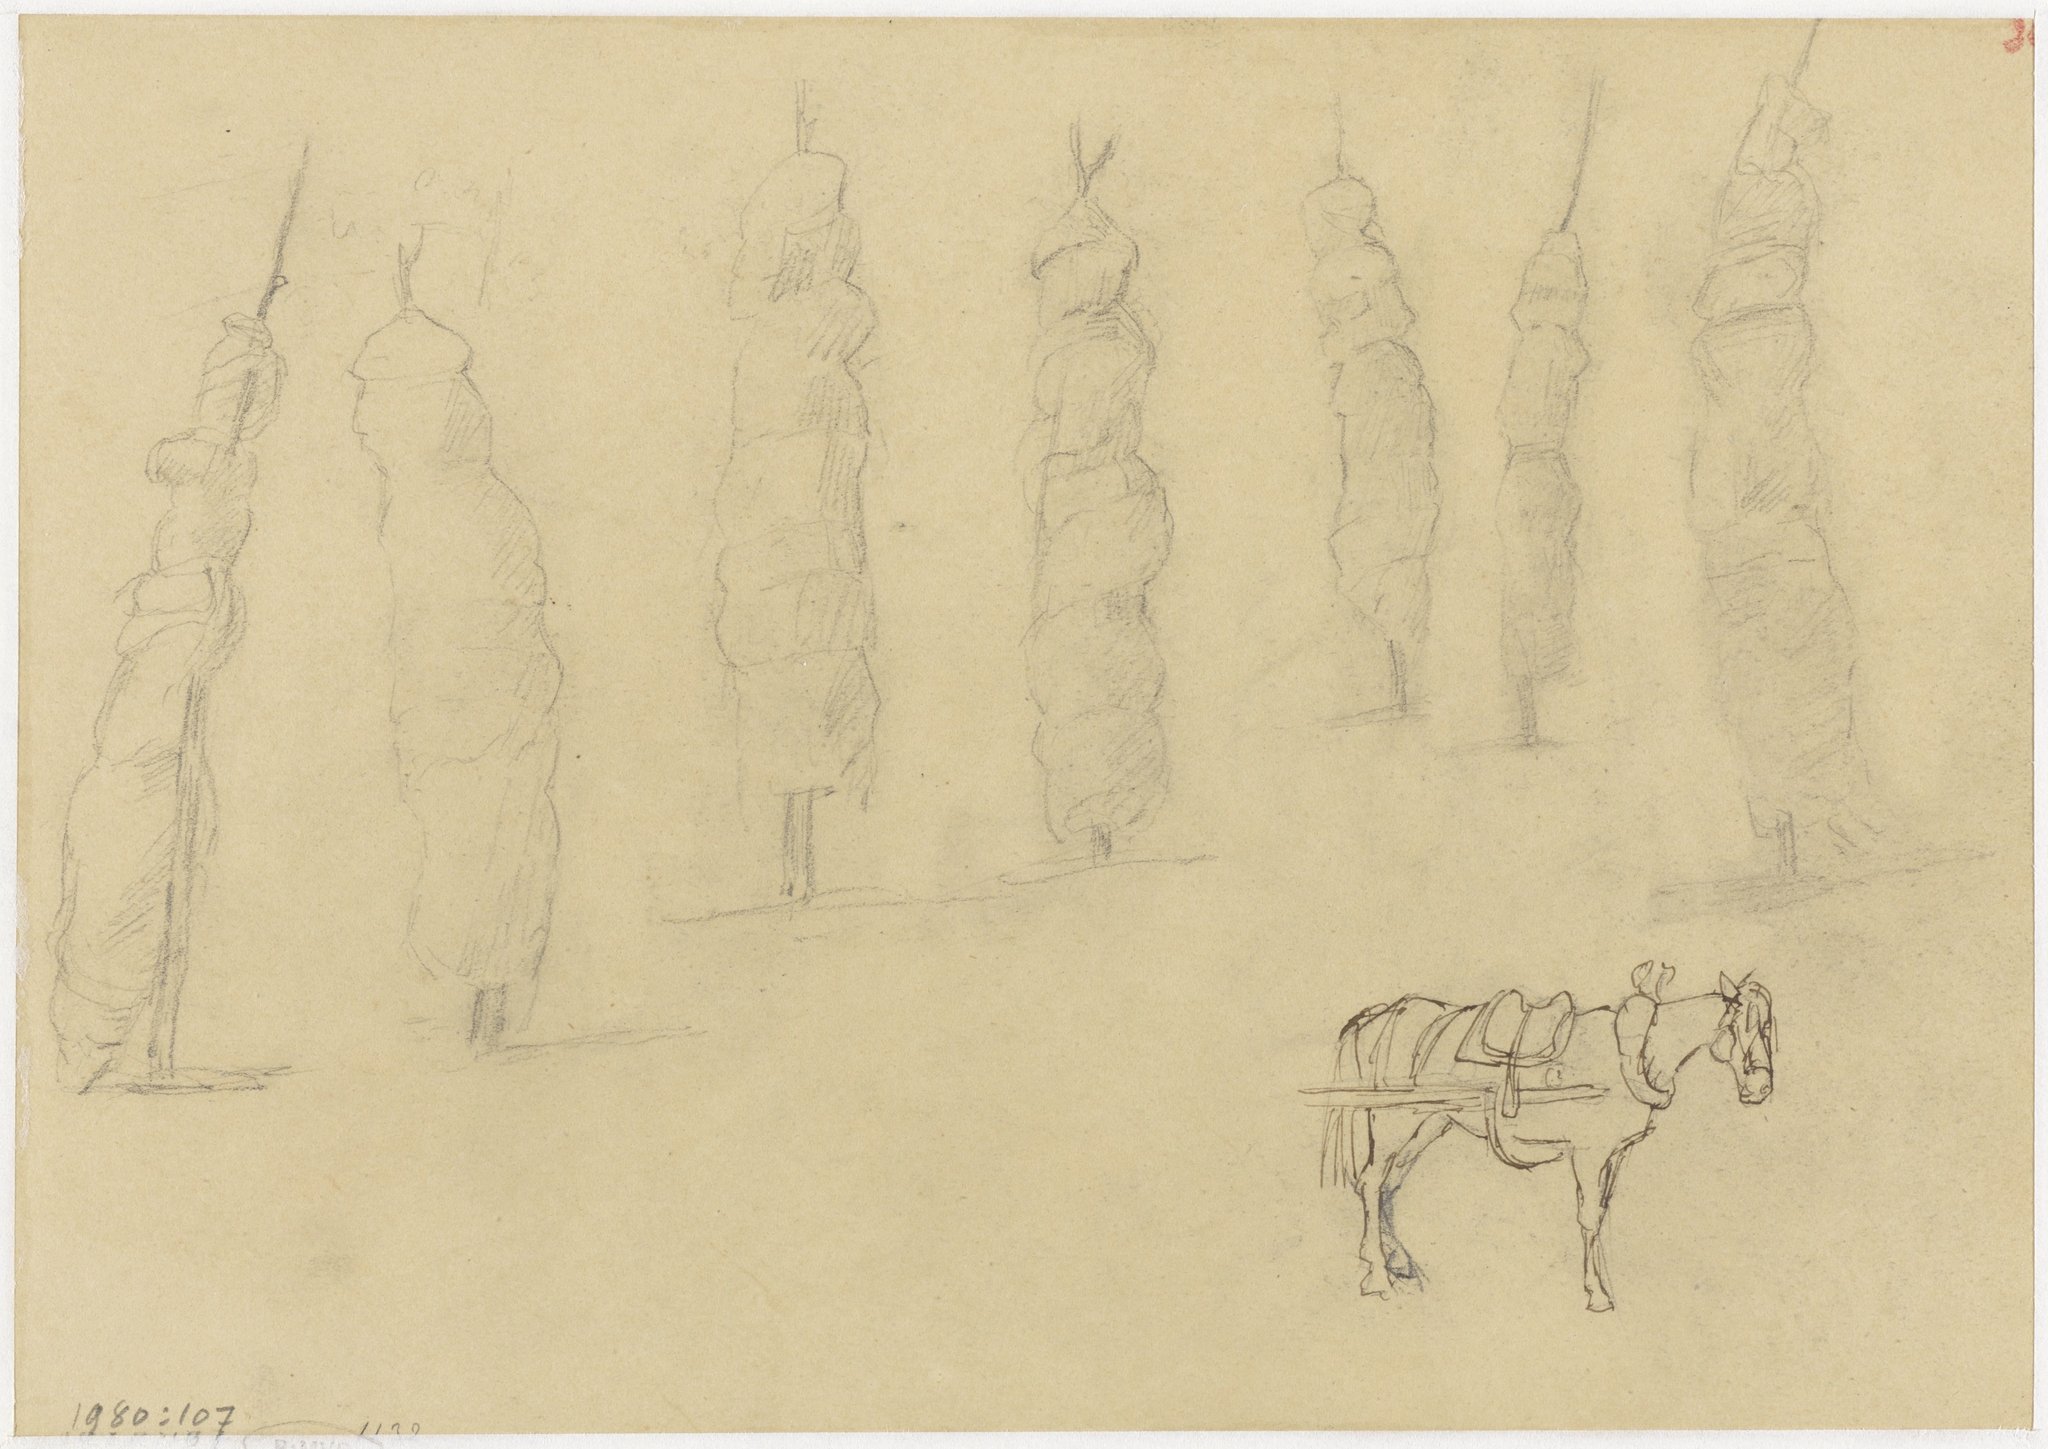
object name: drawing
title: Zeven graanschoven en een paard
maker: jozef israëls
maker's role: draughtsman, painter, print maker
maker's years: 1824-1911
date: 1834-1911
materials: chalk, ink, paper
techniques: pen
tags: horse